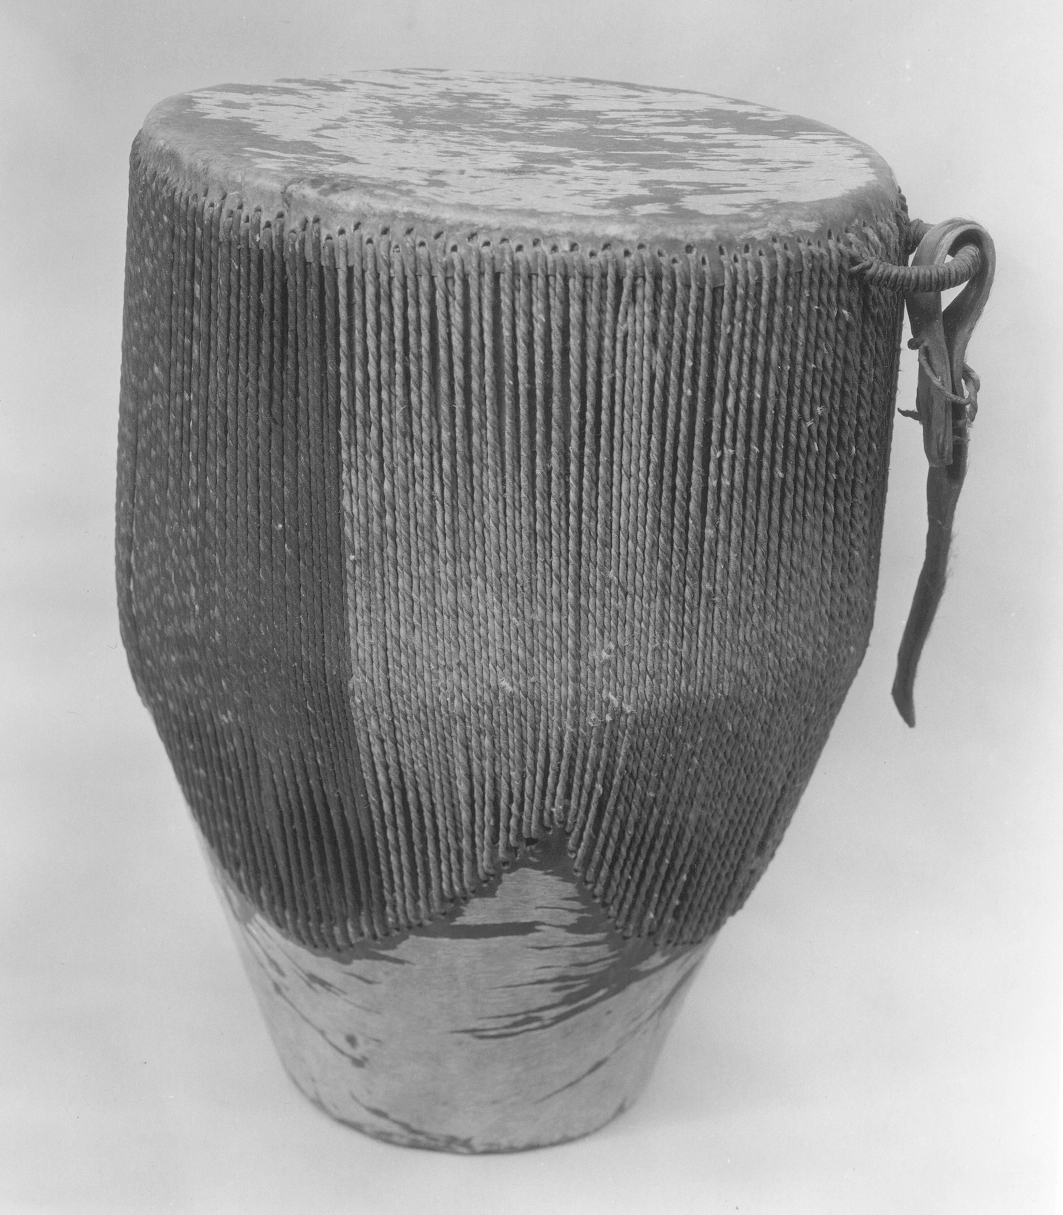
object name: 'uganda drum'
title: 'Uganda' Drum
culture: ugandan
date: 1801-1900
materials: wood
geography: uganda